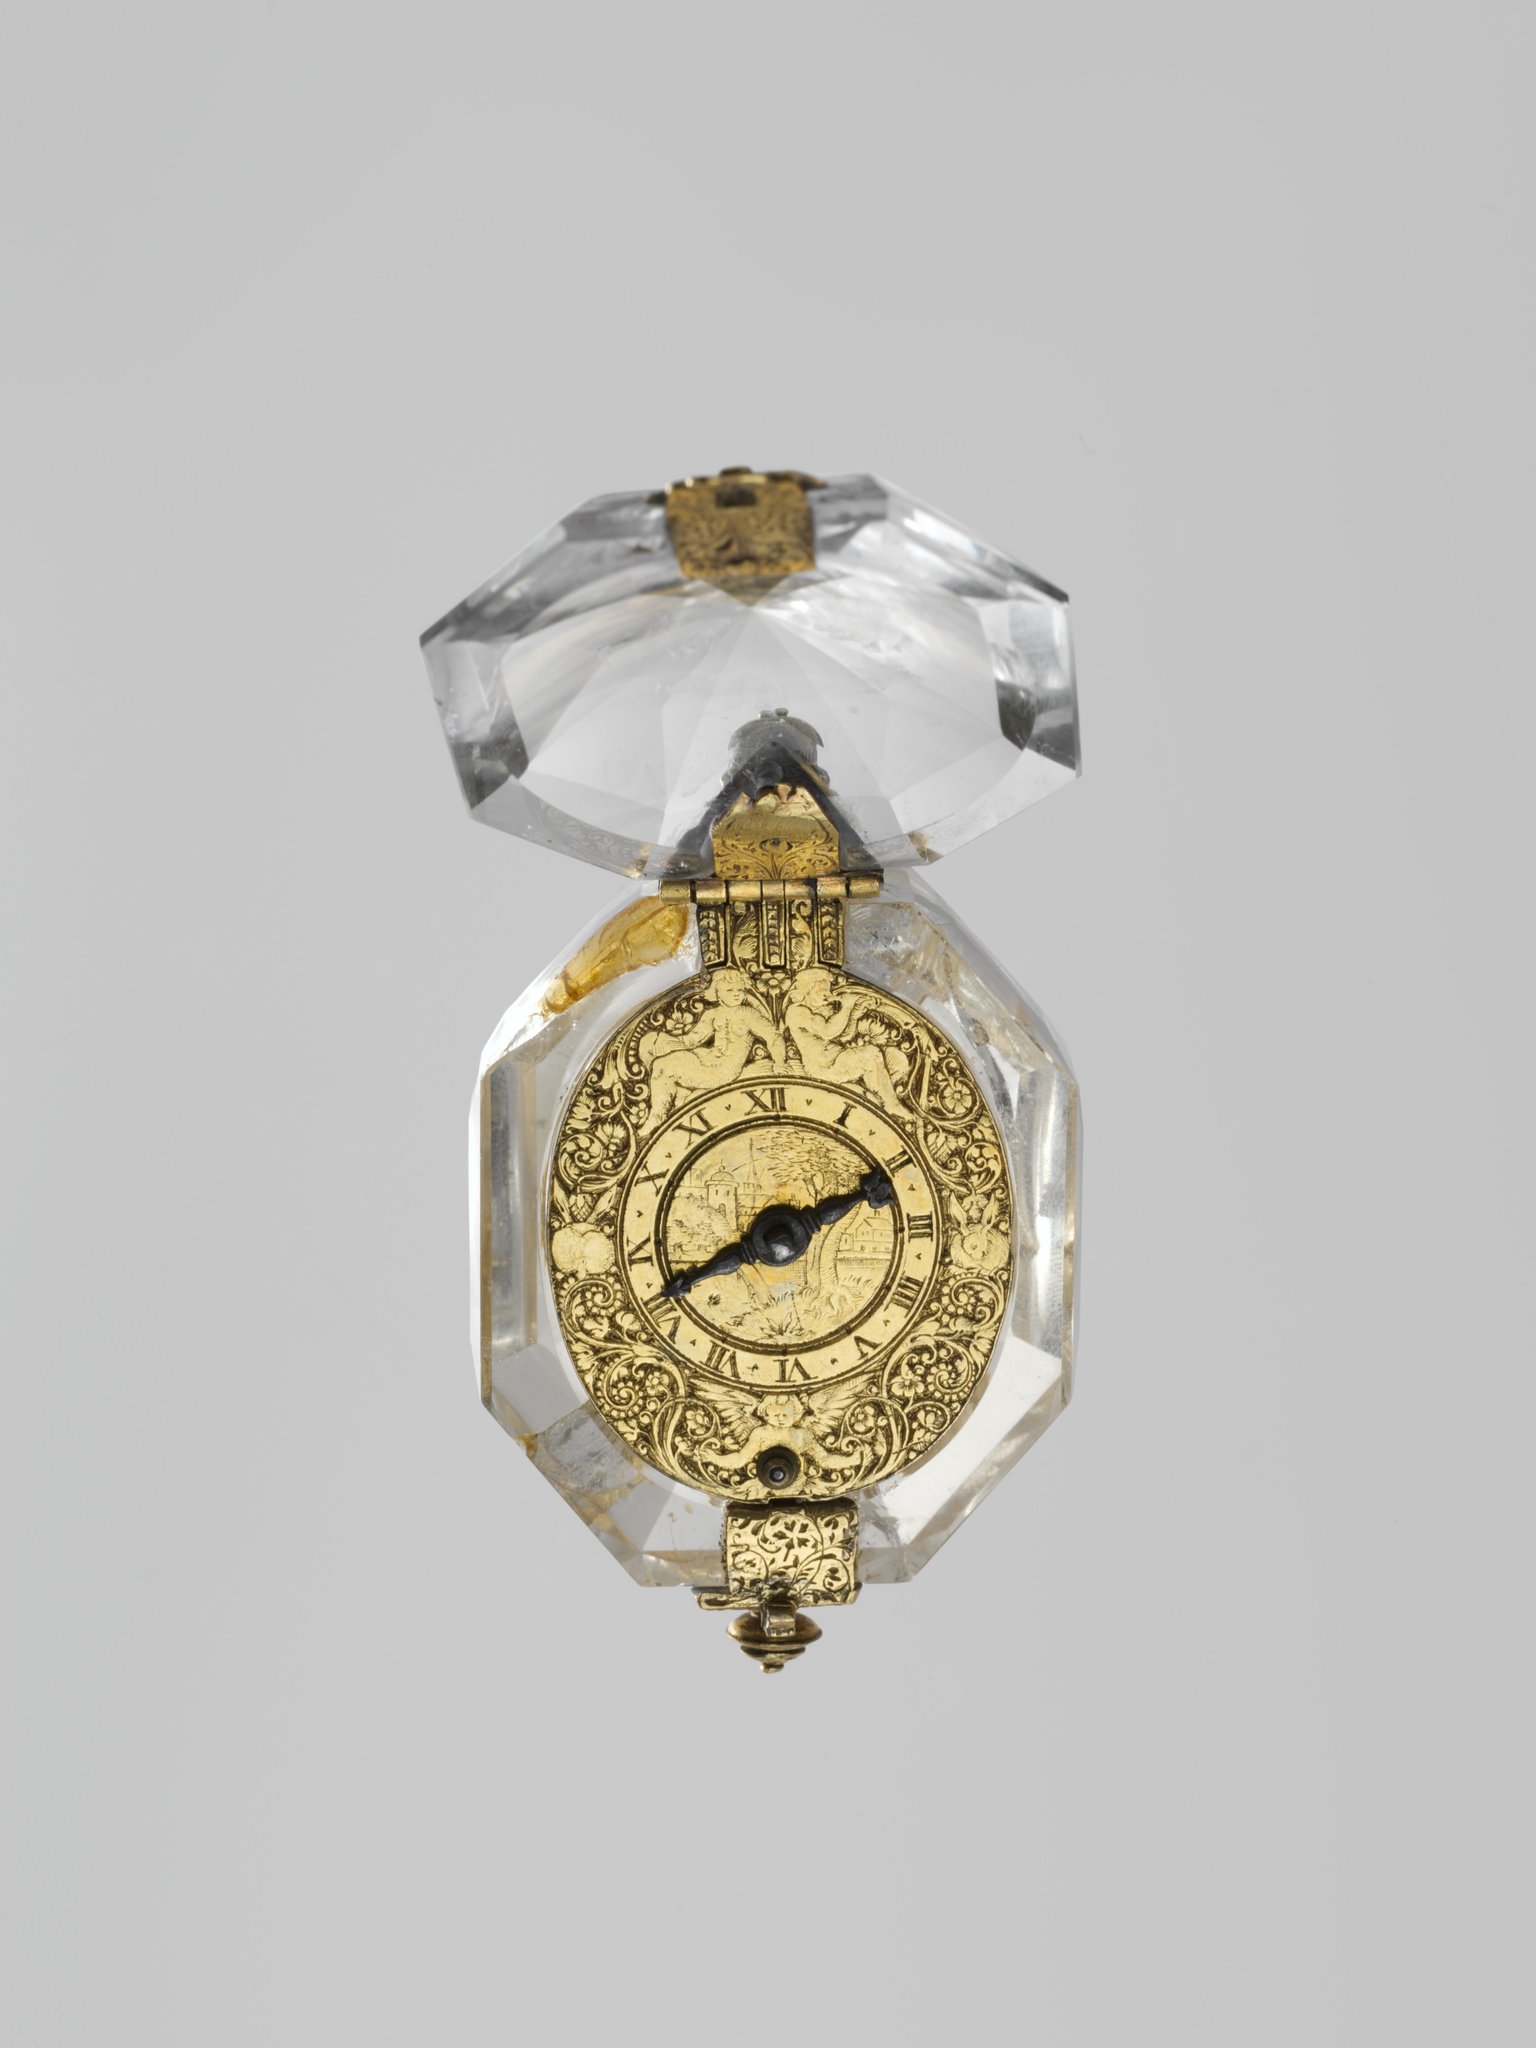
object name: watch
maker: nicolas bernard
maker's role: maker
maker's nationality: french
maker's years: 1530-1620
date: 1570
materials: gilt, metal, quartz